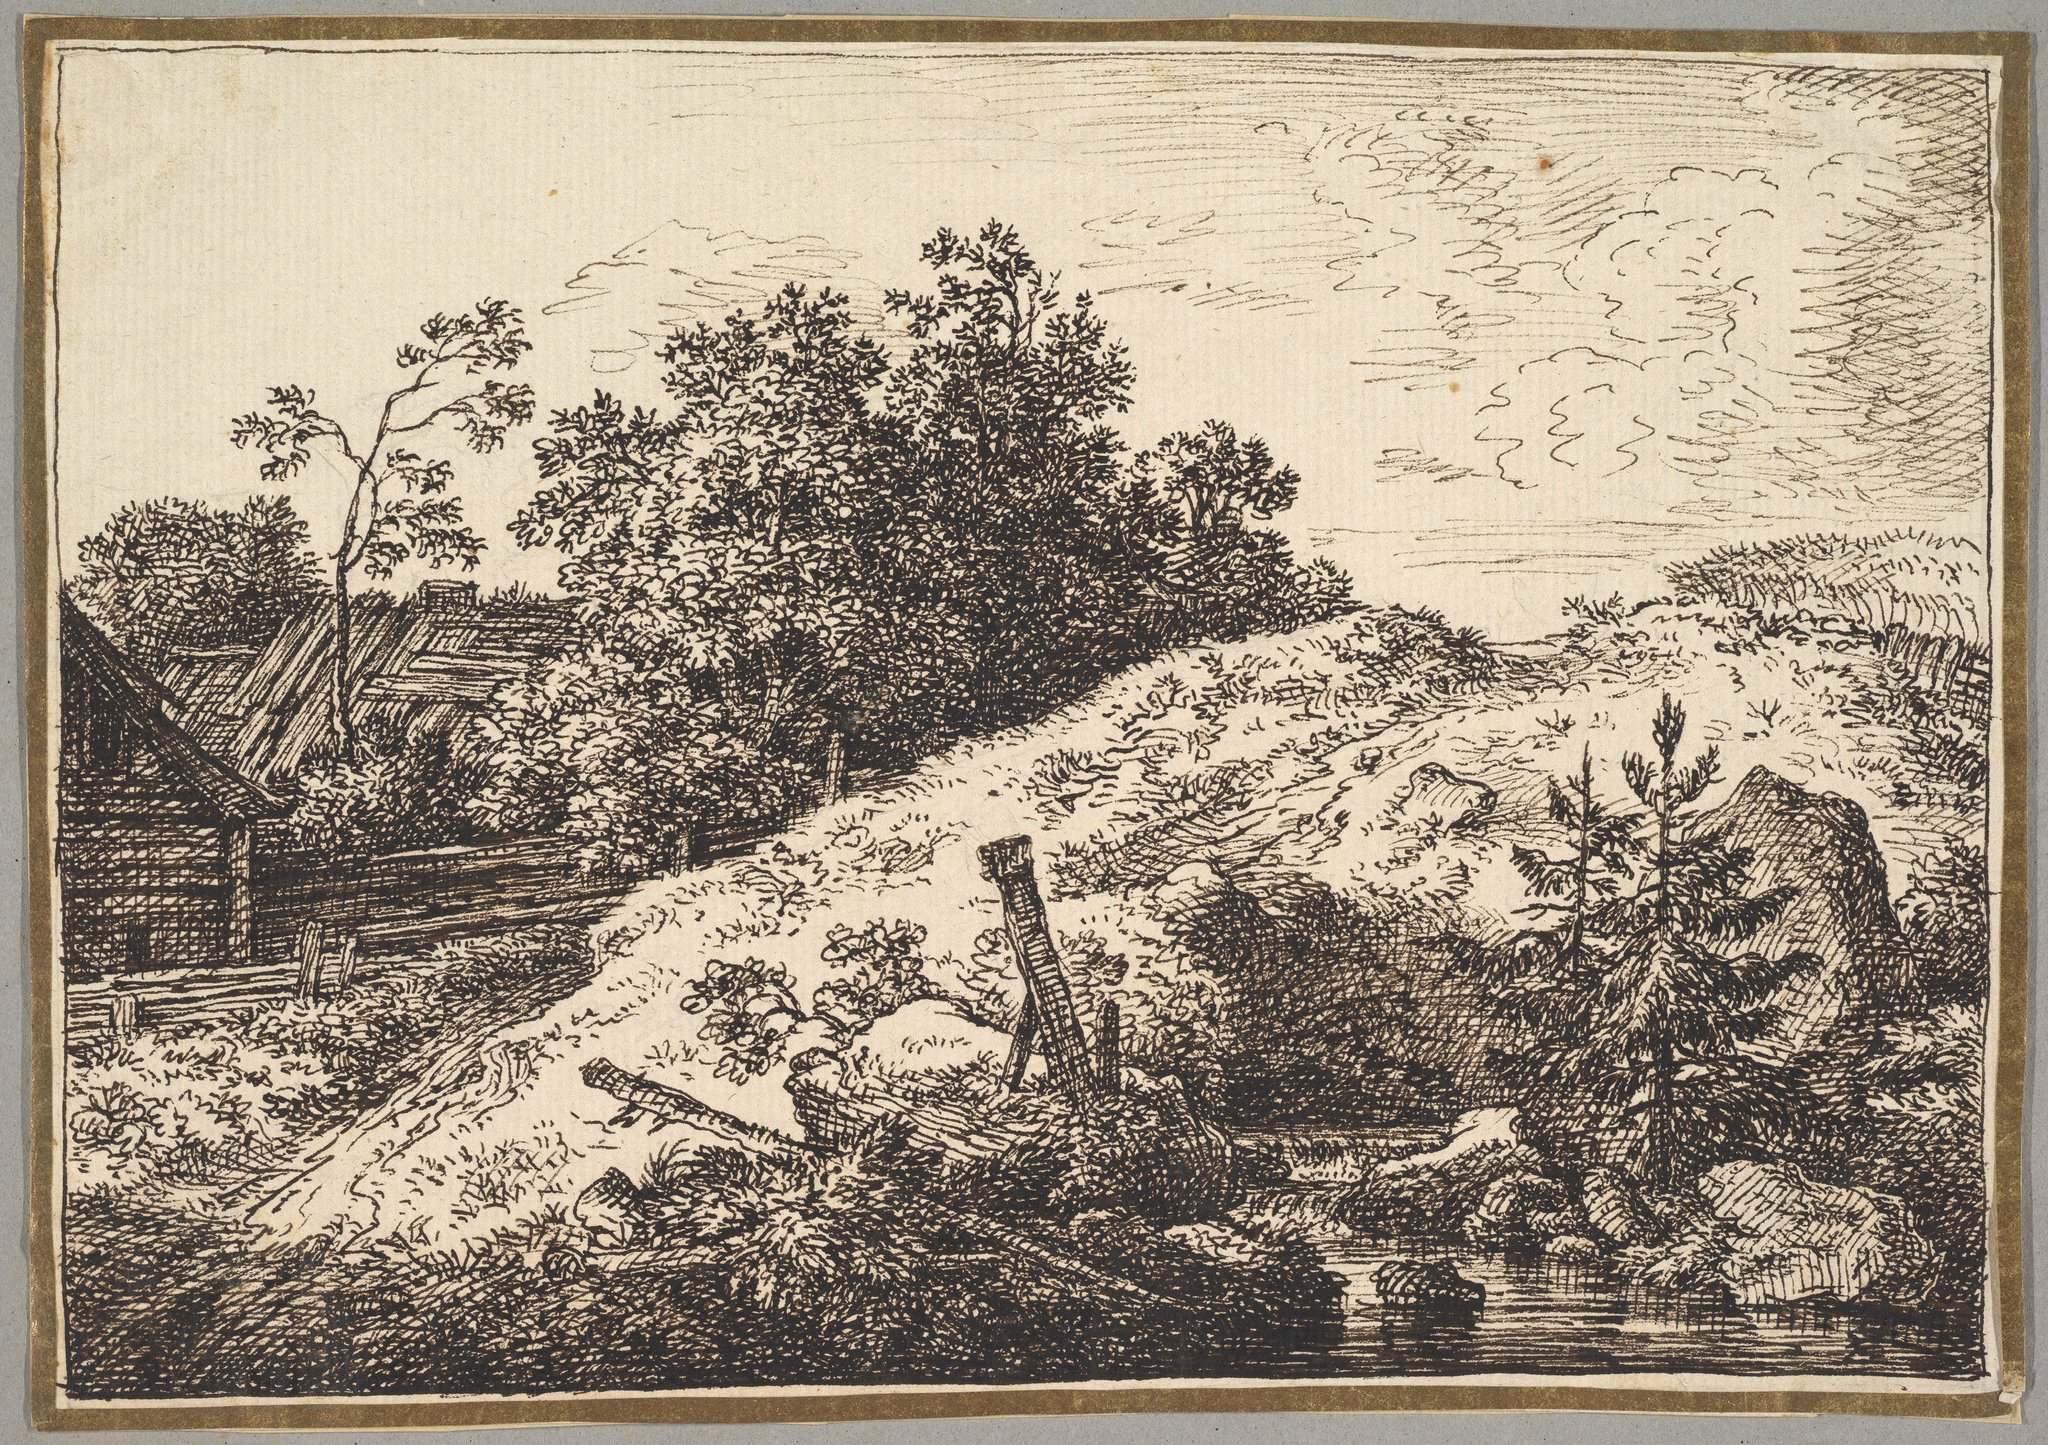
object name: drawing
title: Landscape with a Brook and Farm Buildings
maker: ferdinand kobell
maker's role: artist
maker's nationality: german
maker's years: 1740-1799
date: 1767-1800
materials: ink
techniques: pen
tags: landscapes,trees